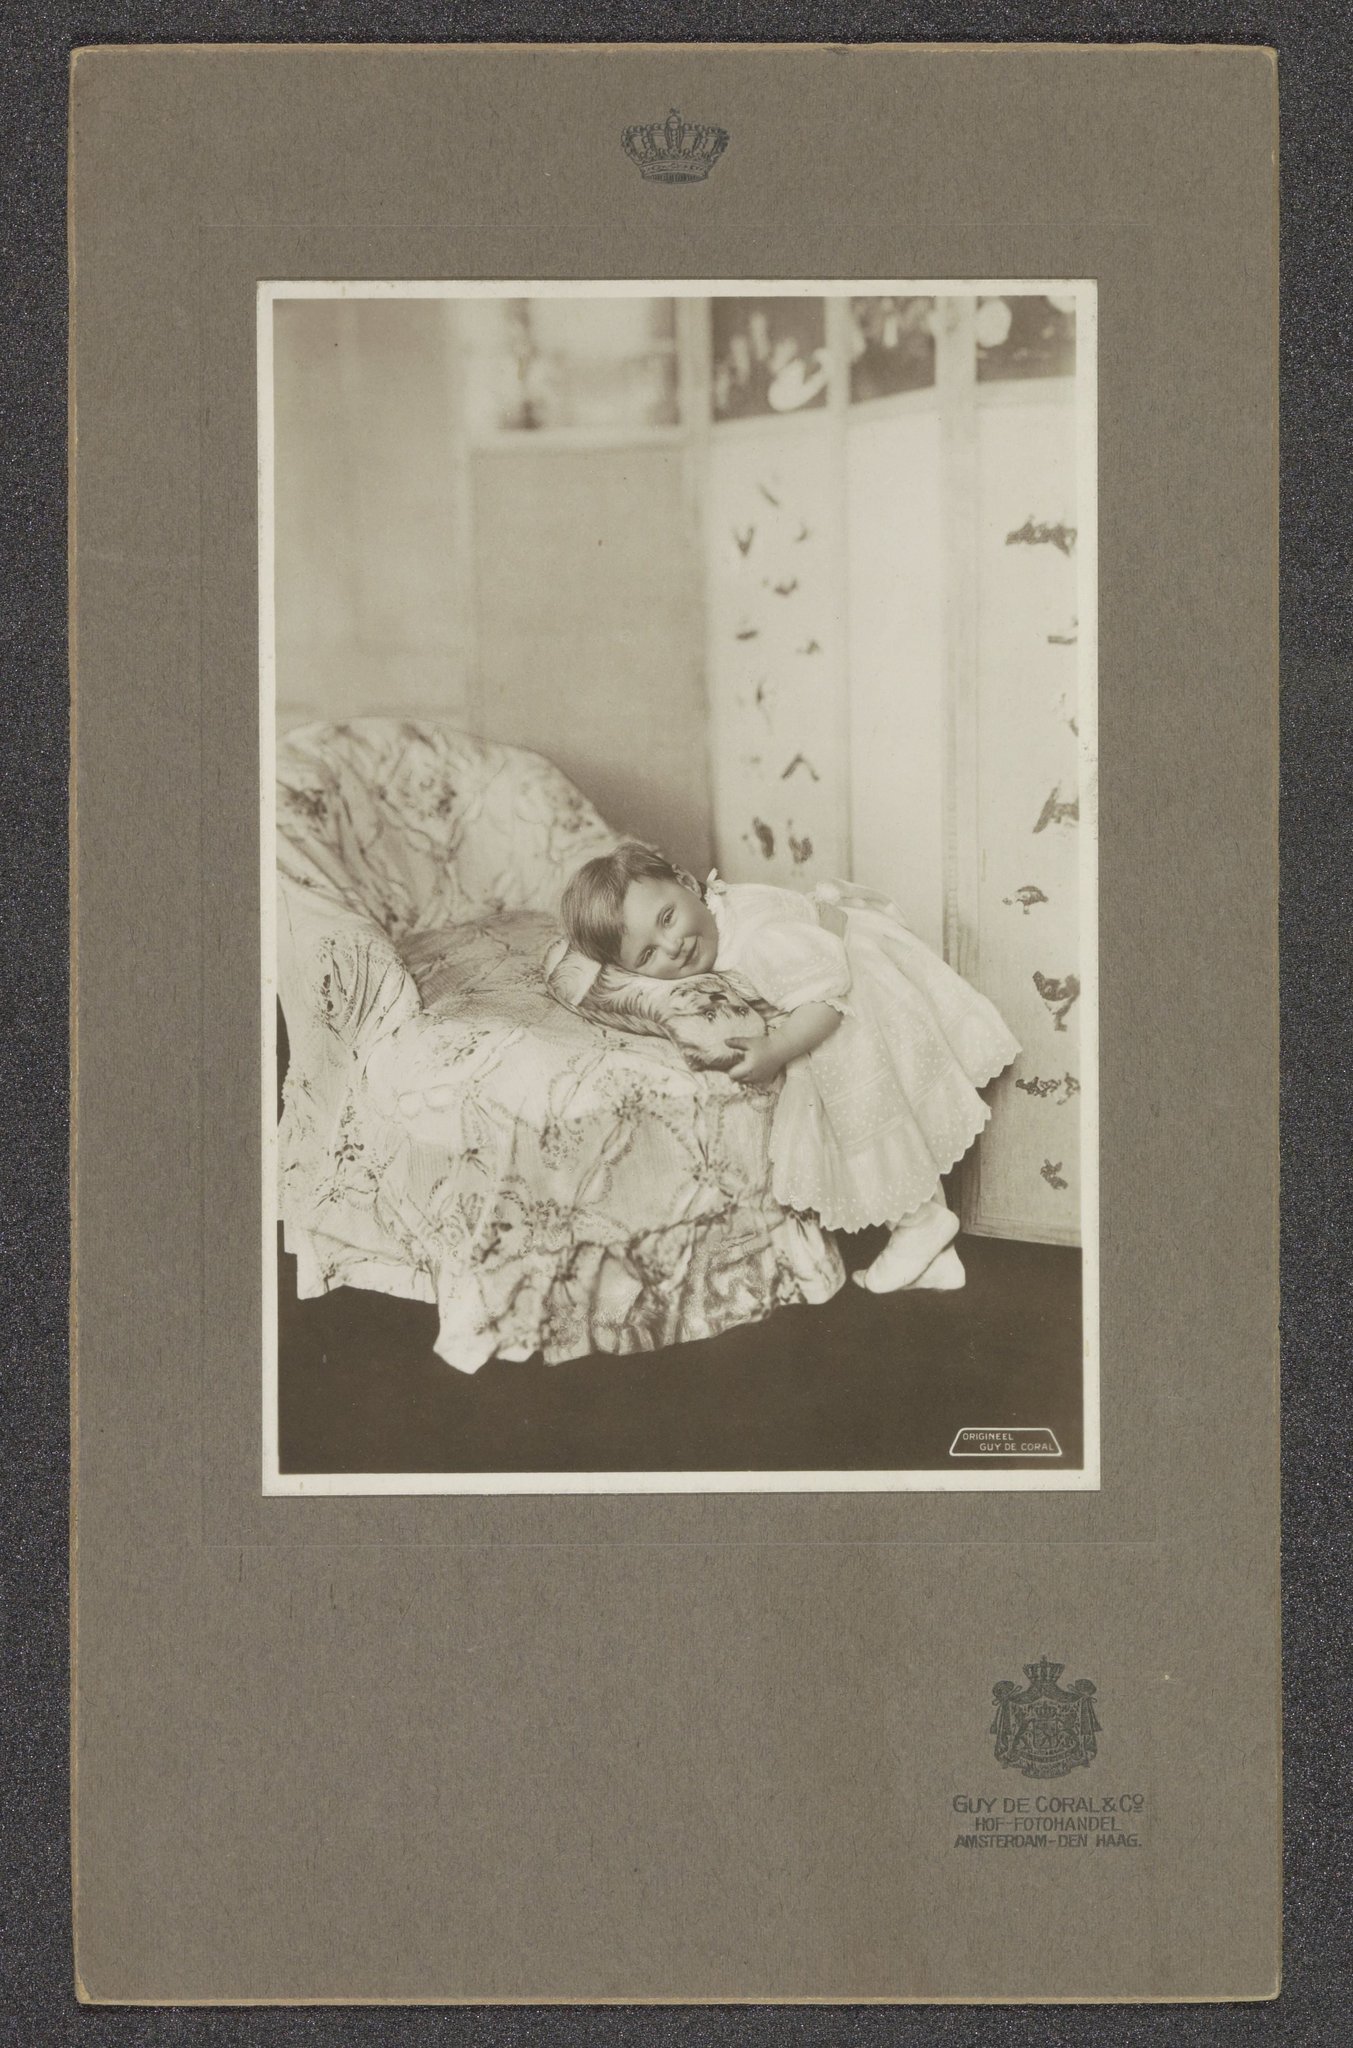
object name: photograph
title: Kinderportret van prinses Juliana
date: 1912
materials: cardboard, paper, photographic support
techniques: matte daylight collodion silver print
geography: amsterdam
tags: the hague, juliana of the netherlands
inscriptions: stamp: ‘Guy de Coral & Co Hof- Fotohandel Amsterdam - Den Haag’